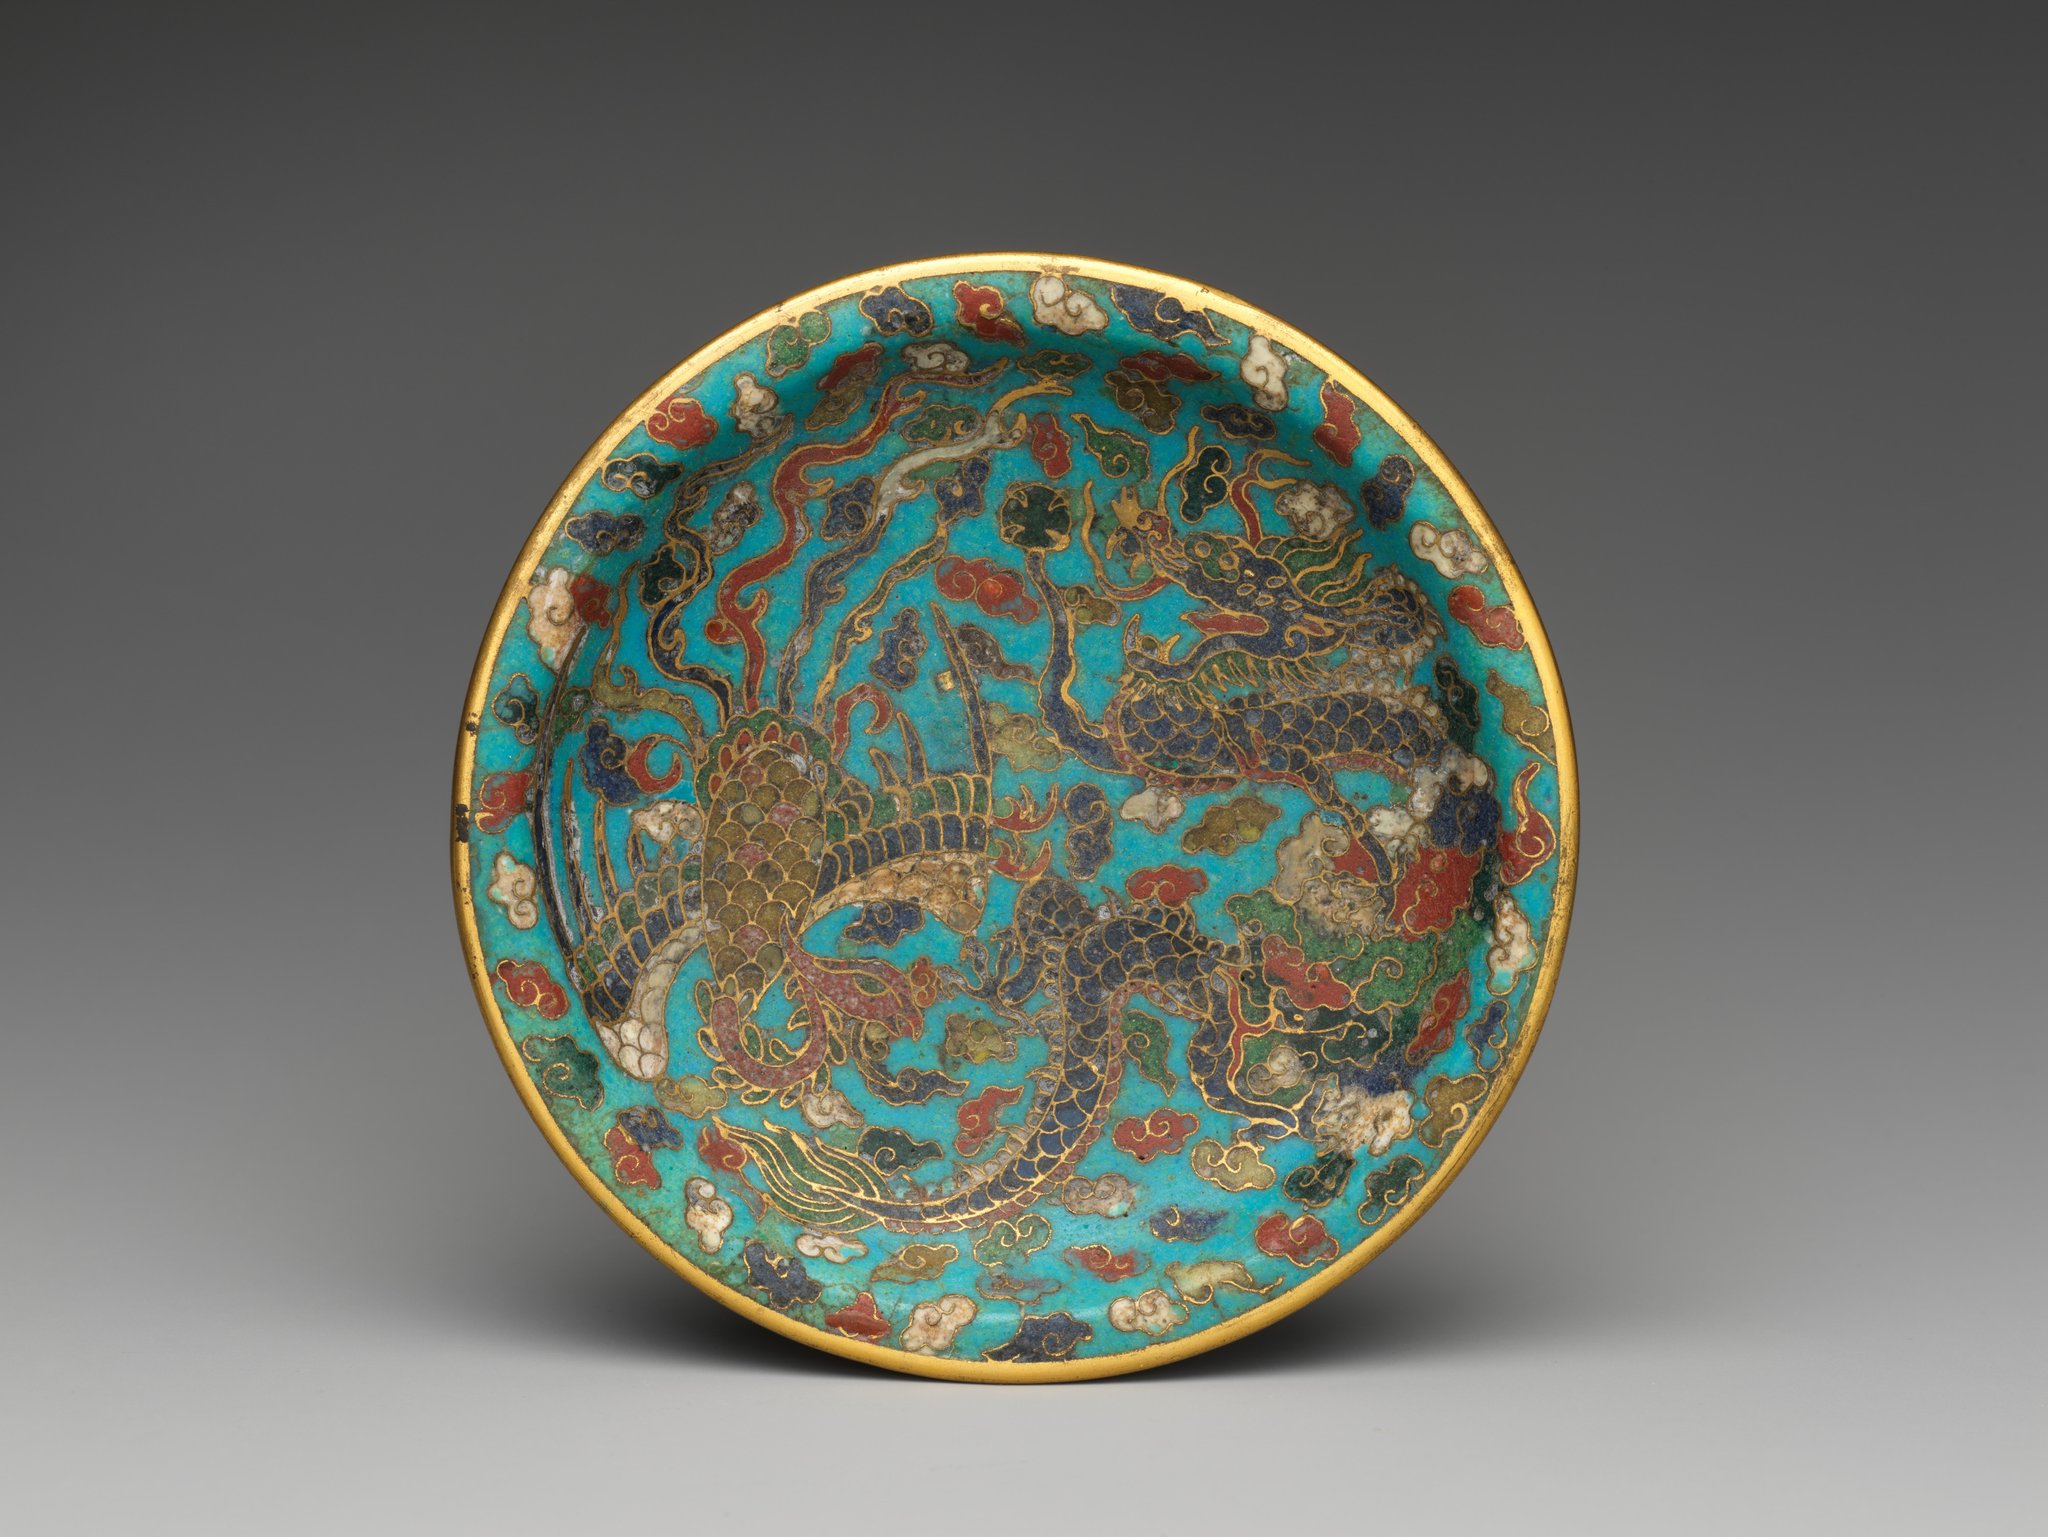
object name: plate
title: Small plate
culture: chinese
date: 1601-1700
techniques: enamel